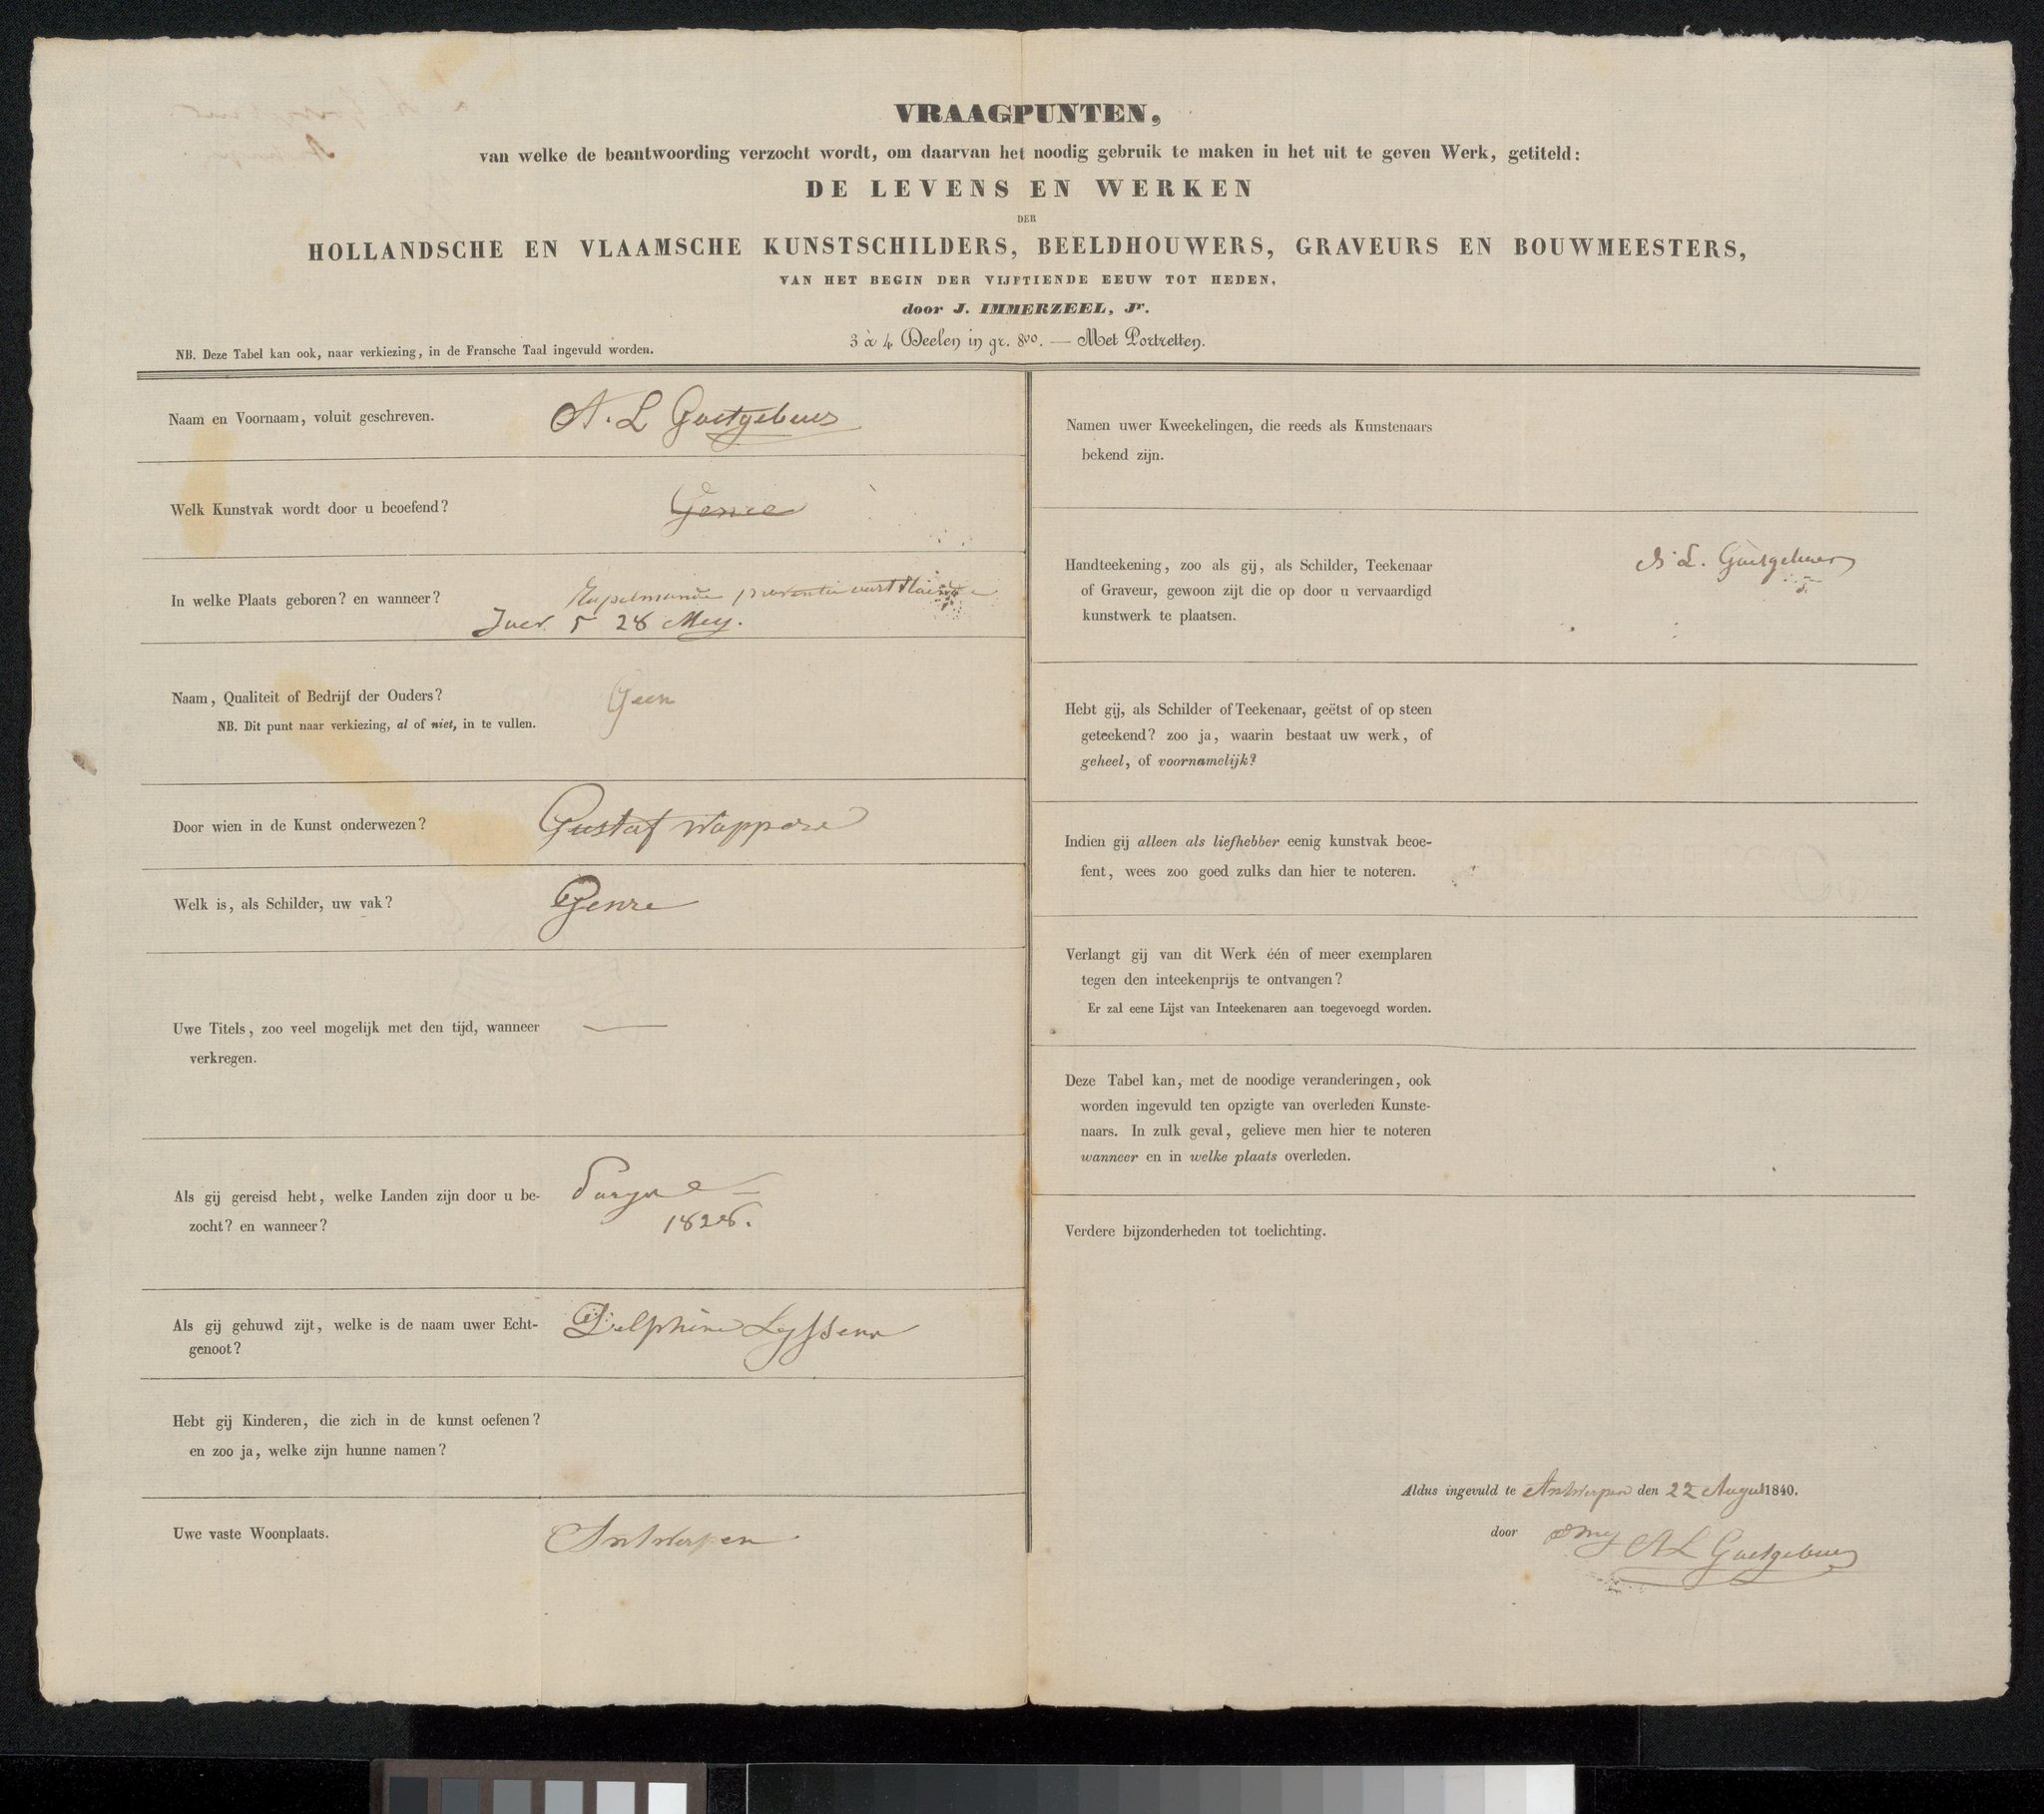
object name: manuscript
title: Enquêteformulier ingevuld door Pierre Jacques Goetghebuer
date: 1840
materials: ink, paper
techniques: pen, printing, writing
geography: antwerp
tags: ghent, print maker, pierre jacques goetghebuer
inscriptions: inscription: ‘Vraagpunten,/ van welke de beantwoording verzocht wordt, om daarvan het noodig gebruik te maken in het uit te geven Werk, getiteld: De levens en werken/ der Hollandsche en Vlaamsche kunstschilders, beeldhouwers,/ graveurs en bouwmeesters, van het begin der vijftiende eeuw tot heden/ door J. Immerzeel, Jr.’, watermark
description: Opgenomen in: Immerzeel, J. Jr., De levens en werken der Hollandsche en Vlaamsche kunstschilders, beeldhouwers, graveurs en bouwmeesters, van het begin der vijftiende eeuw tot heden, Amsterdam: J.C. van Kesteren, 1842-1843.